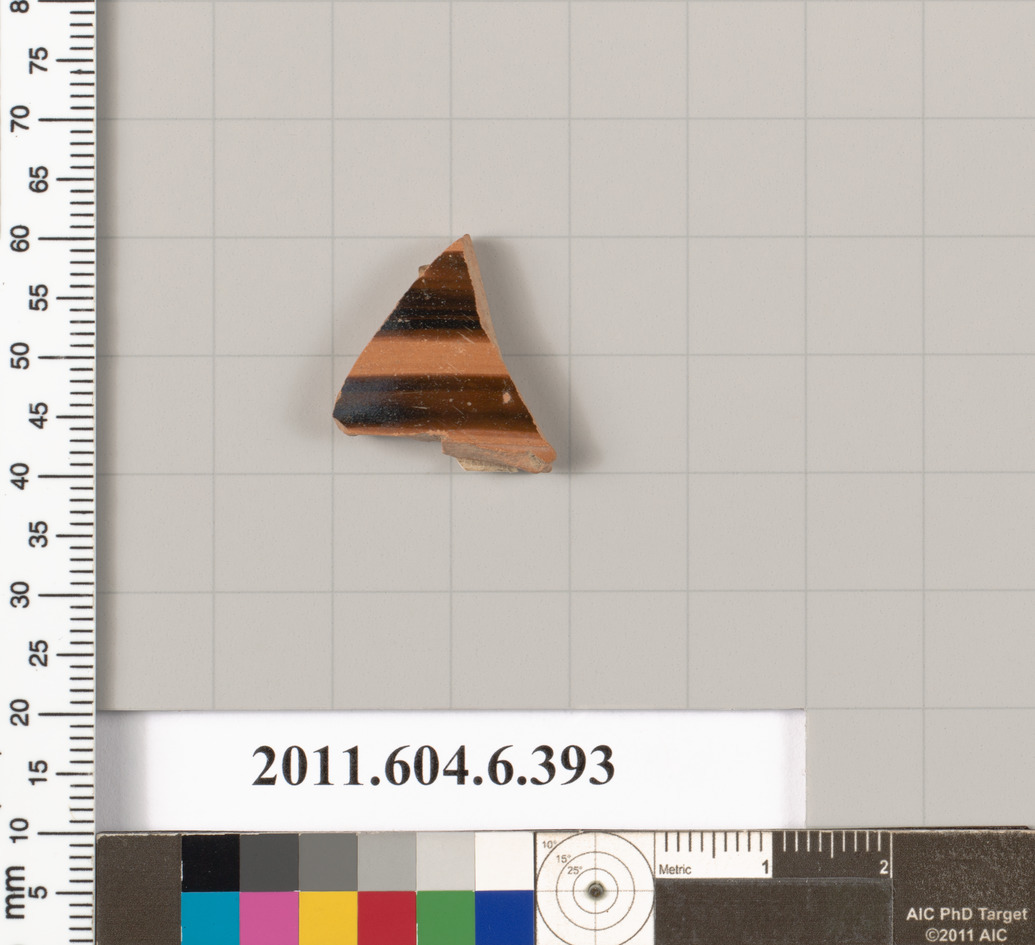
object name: undetermined closed shape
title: Terracotta fragment of a closed shape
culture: greek, attic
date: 600-401 BCE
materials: terracotta